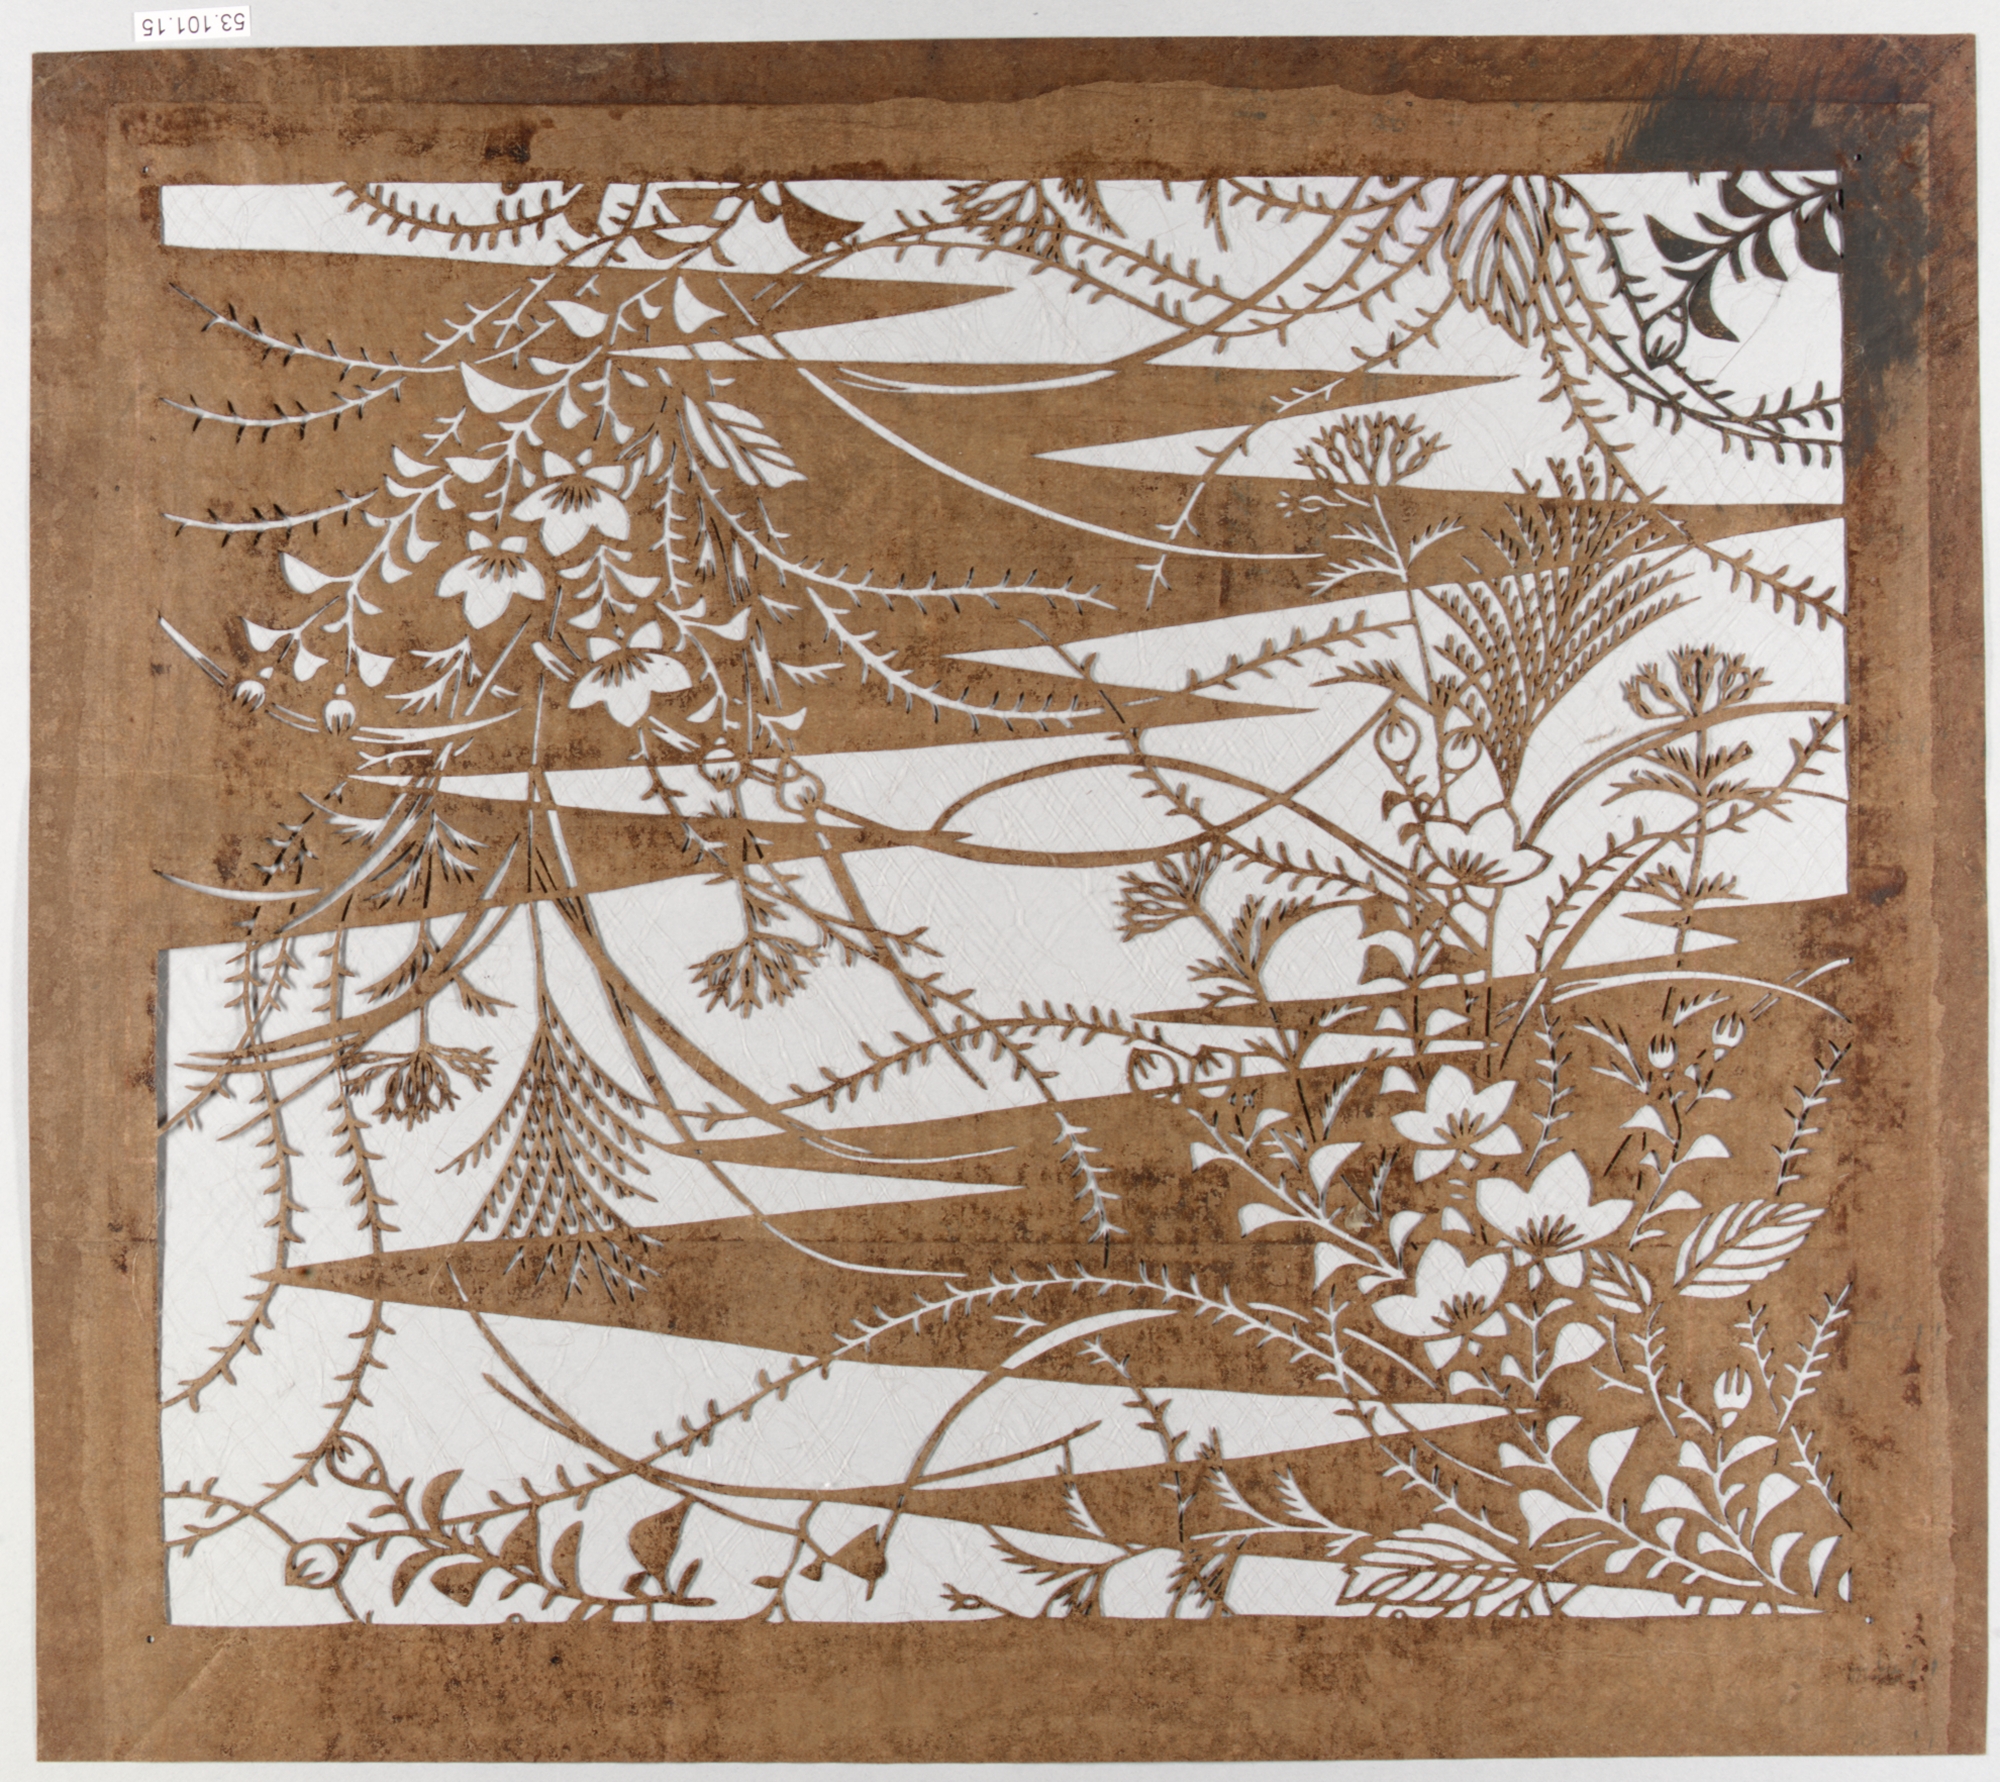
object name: stencil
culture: japanese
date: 1615-1868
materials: paper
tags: flowers,plants